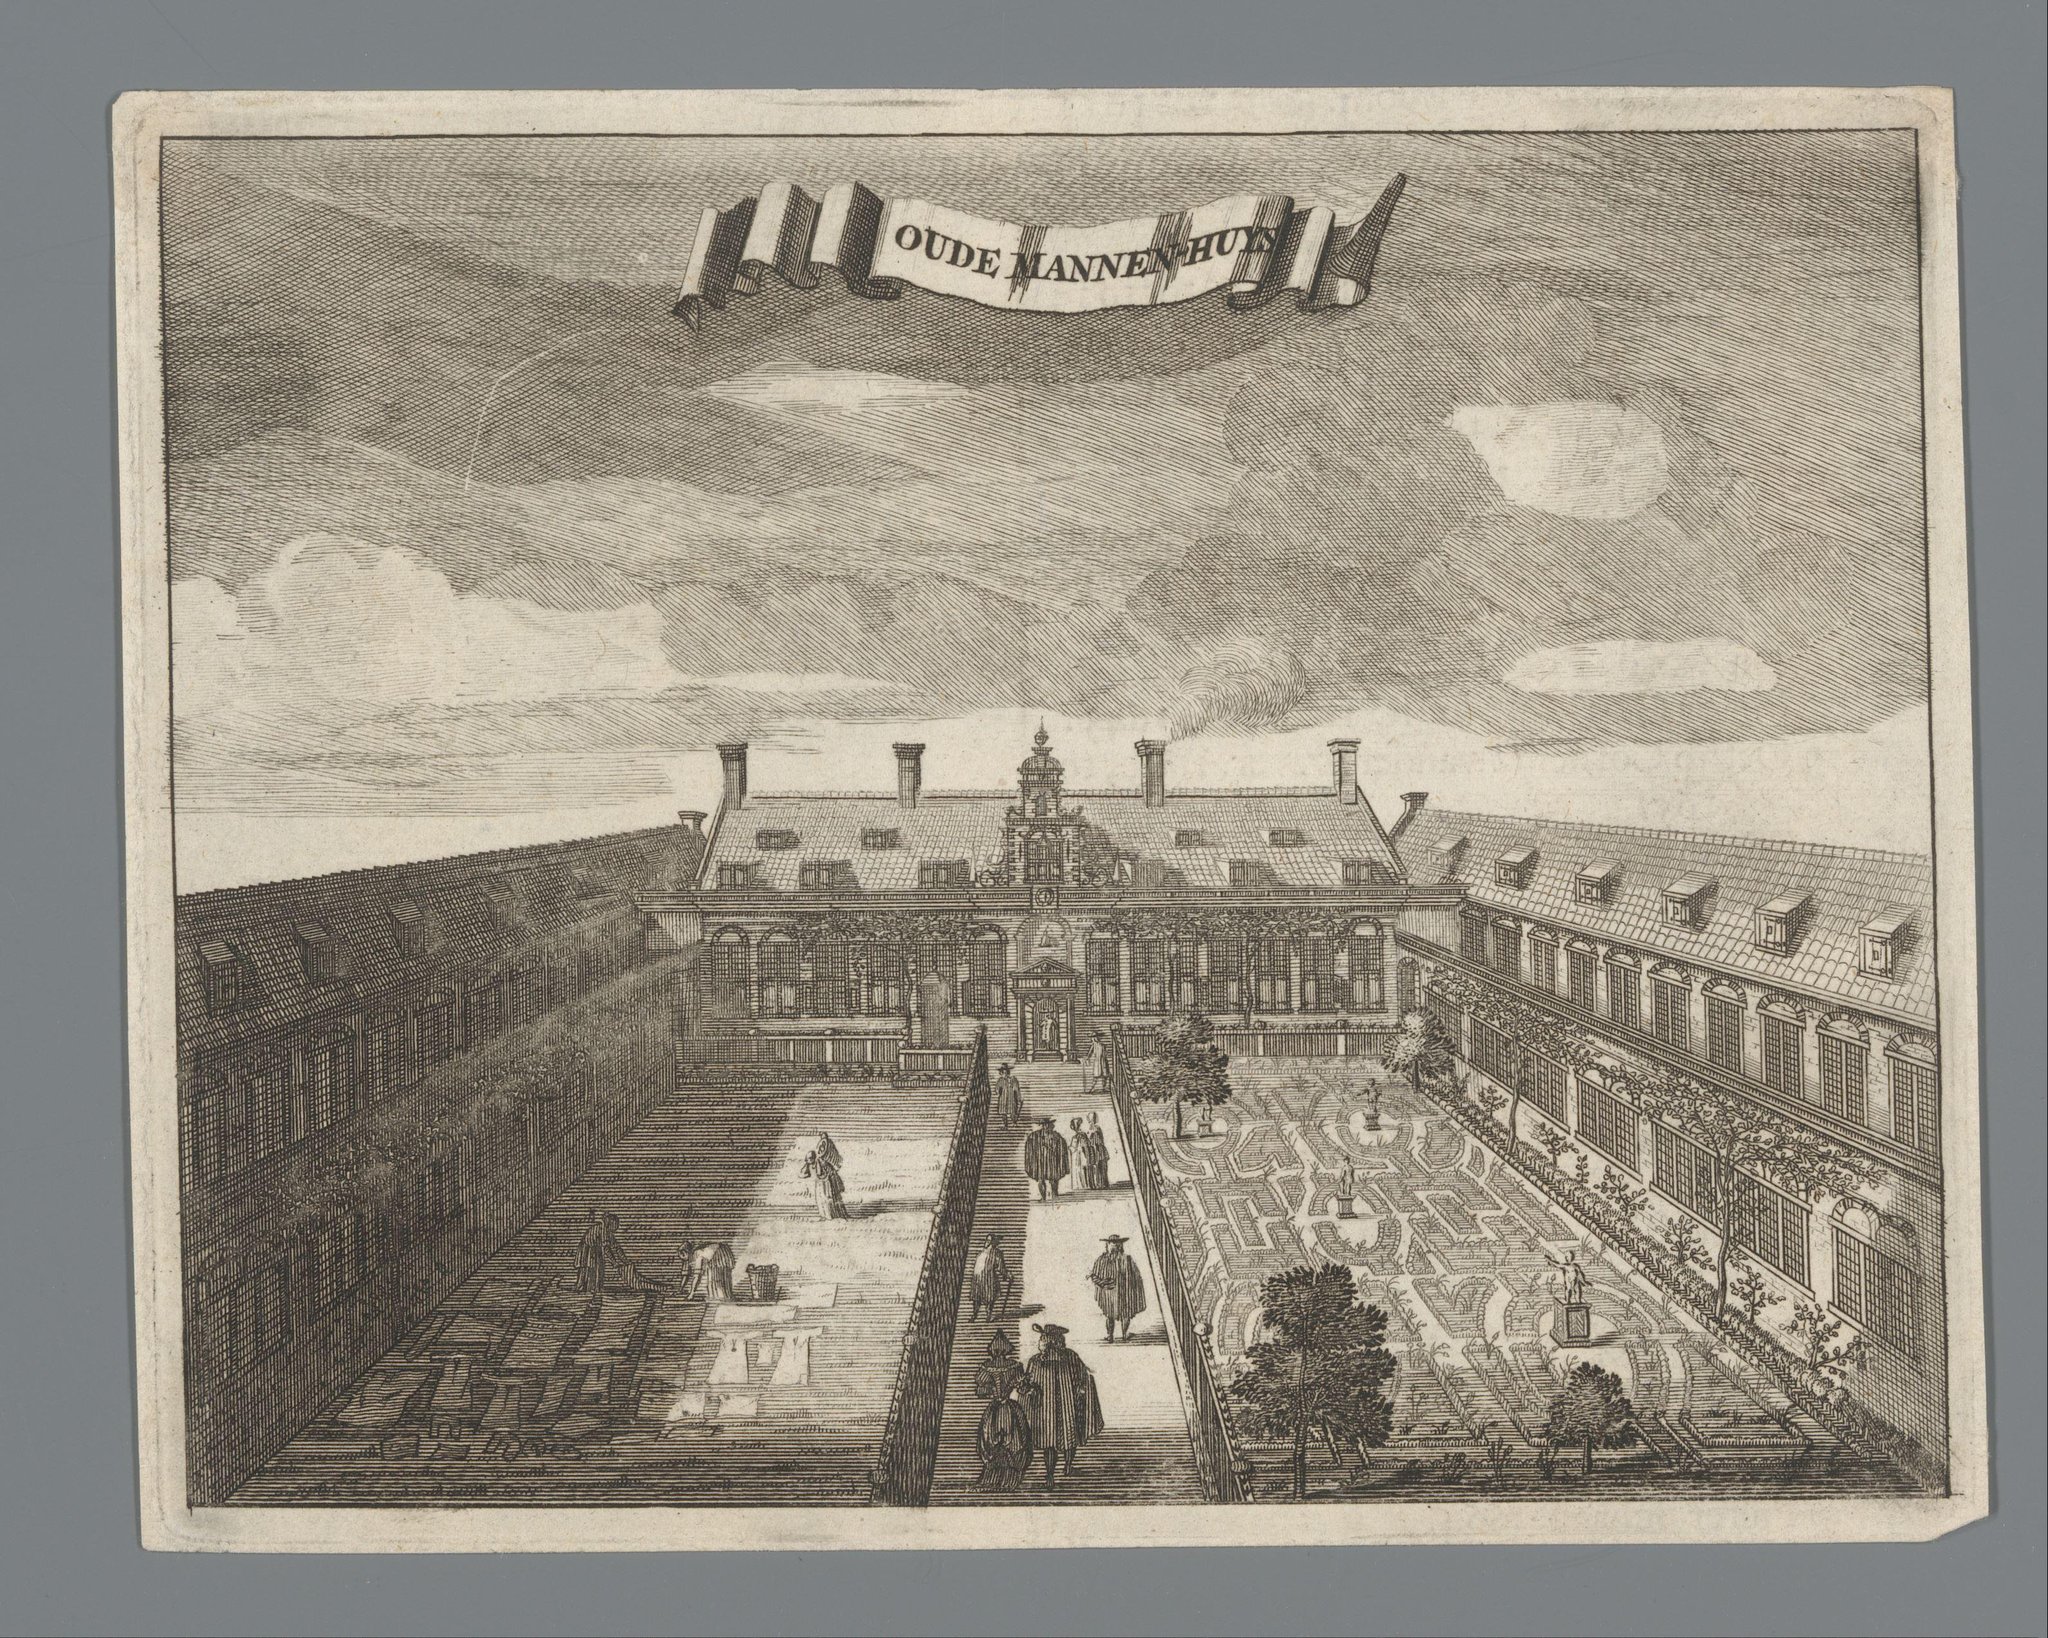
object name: print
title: Gezicht op de binnenplaats van het Oudemannenhuis te Amsterdam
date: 1726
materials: paper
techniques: etching, letterpress printing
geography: amsterdam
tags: public welfare, courtyard, old-people's home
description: Prent uit: Commelin, Caspar. Beschryvinge van Amsterdam, zynde een naukeruige verhandelinge van desselfs eerste oorspronk uyt den Huyse (…). Amsterdam: Andries van Damme et al., 1726, p. 570.